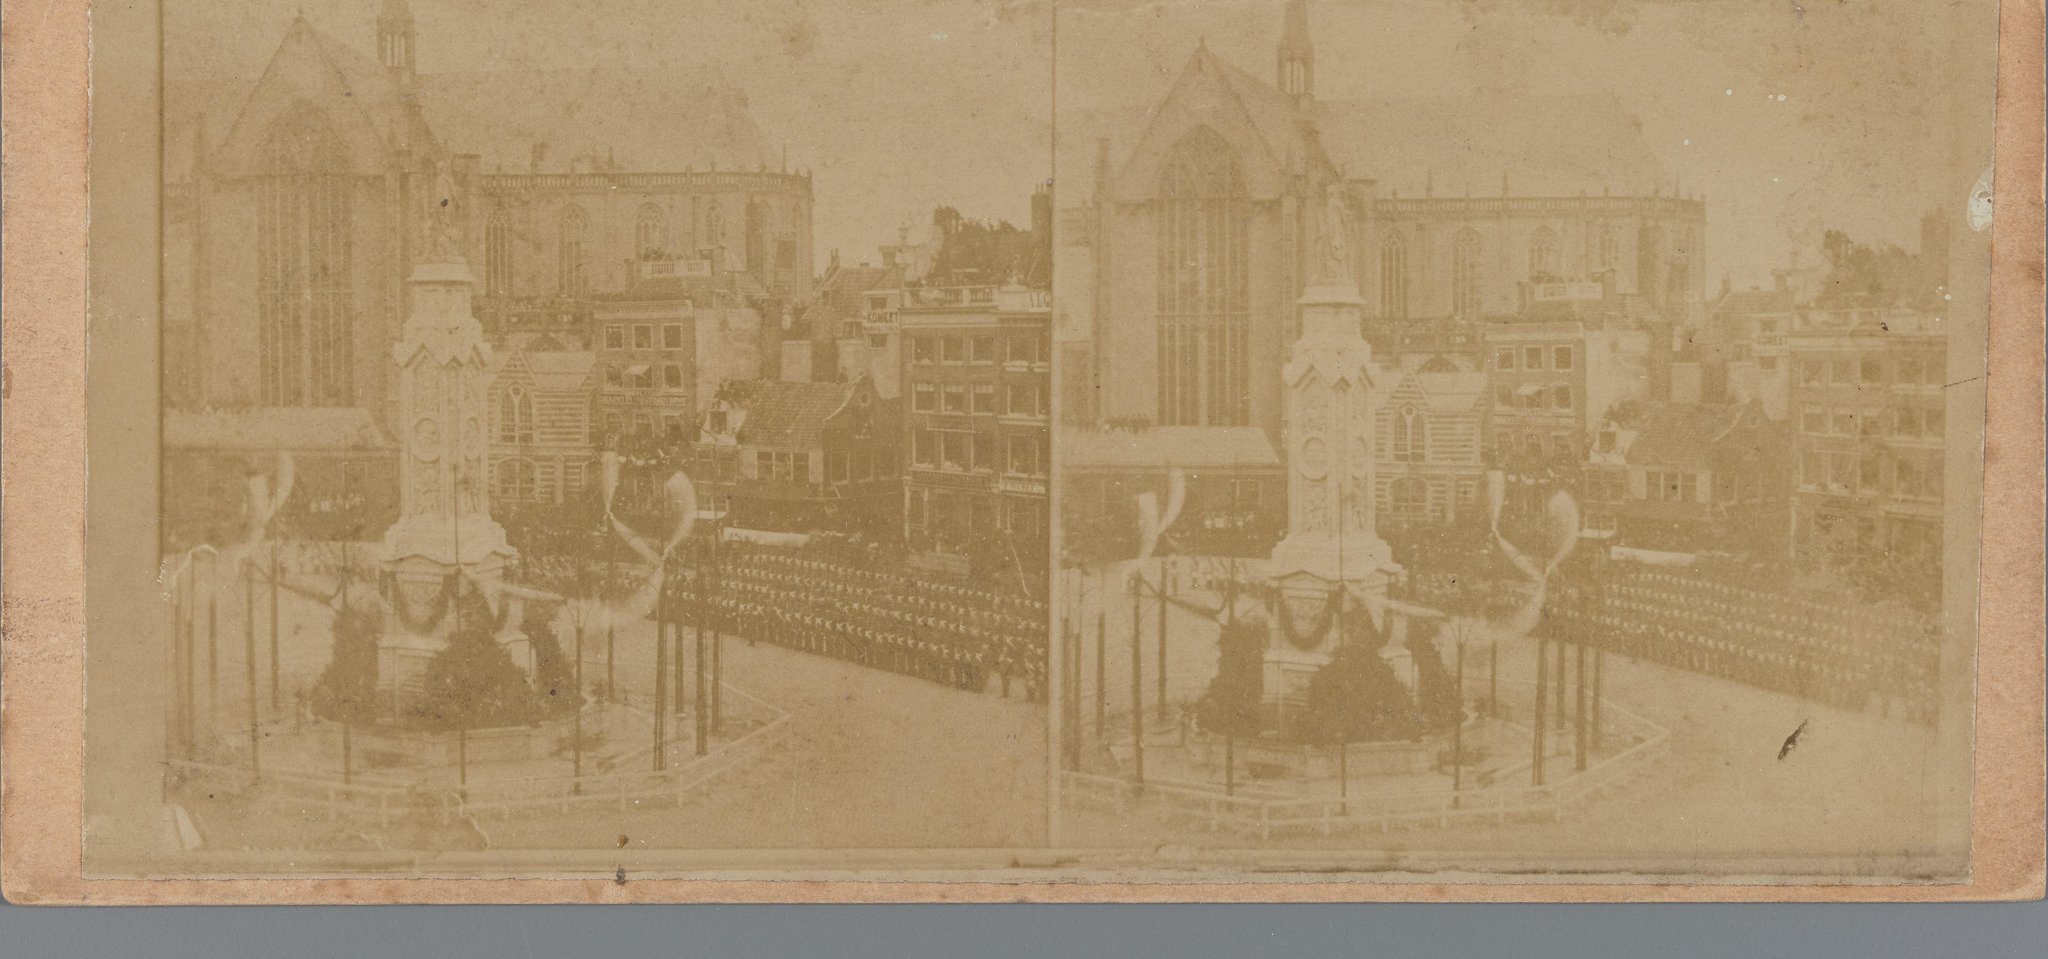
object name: stereograph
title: Onthulling van Naatje (het Monument ter herinnering aan de Volksgeest van 1830-1831) op de Dam in Amsterdam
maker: pieter oosterhuis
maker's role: draughtsman, print maker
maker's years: 1816-1885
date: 1856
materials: cardboard, paper, photographic support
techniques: albumen print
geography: amsterdam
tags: monument, statue, square, place, circus, etc. (+ city(-scape) with figures, staffage), amsterdam